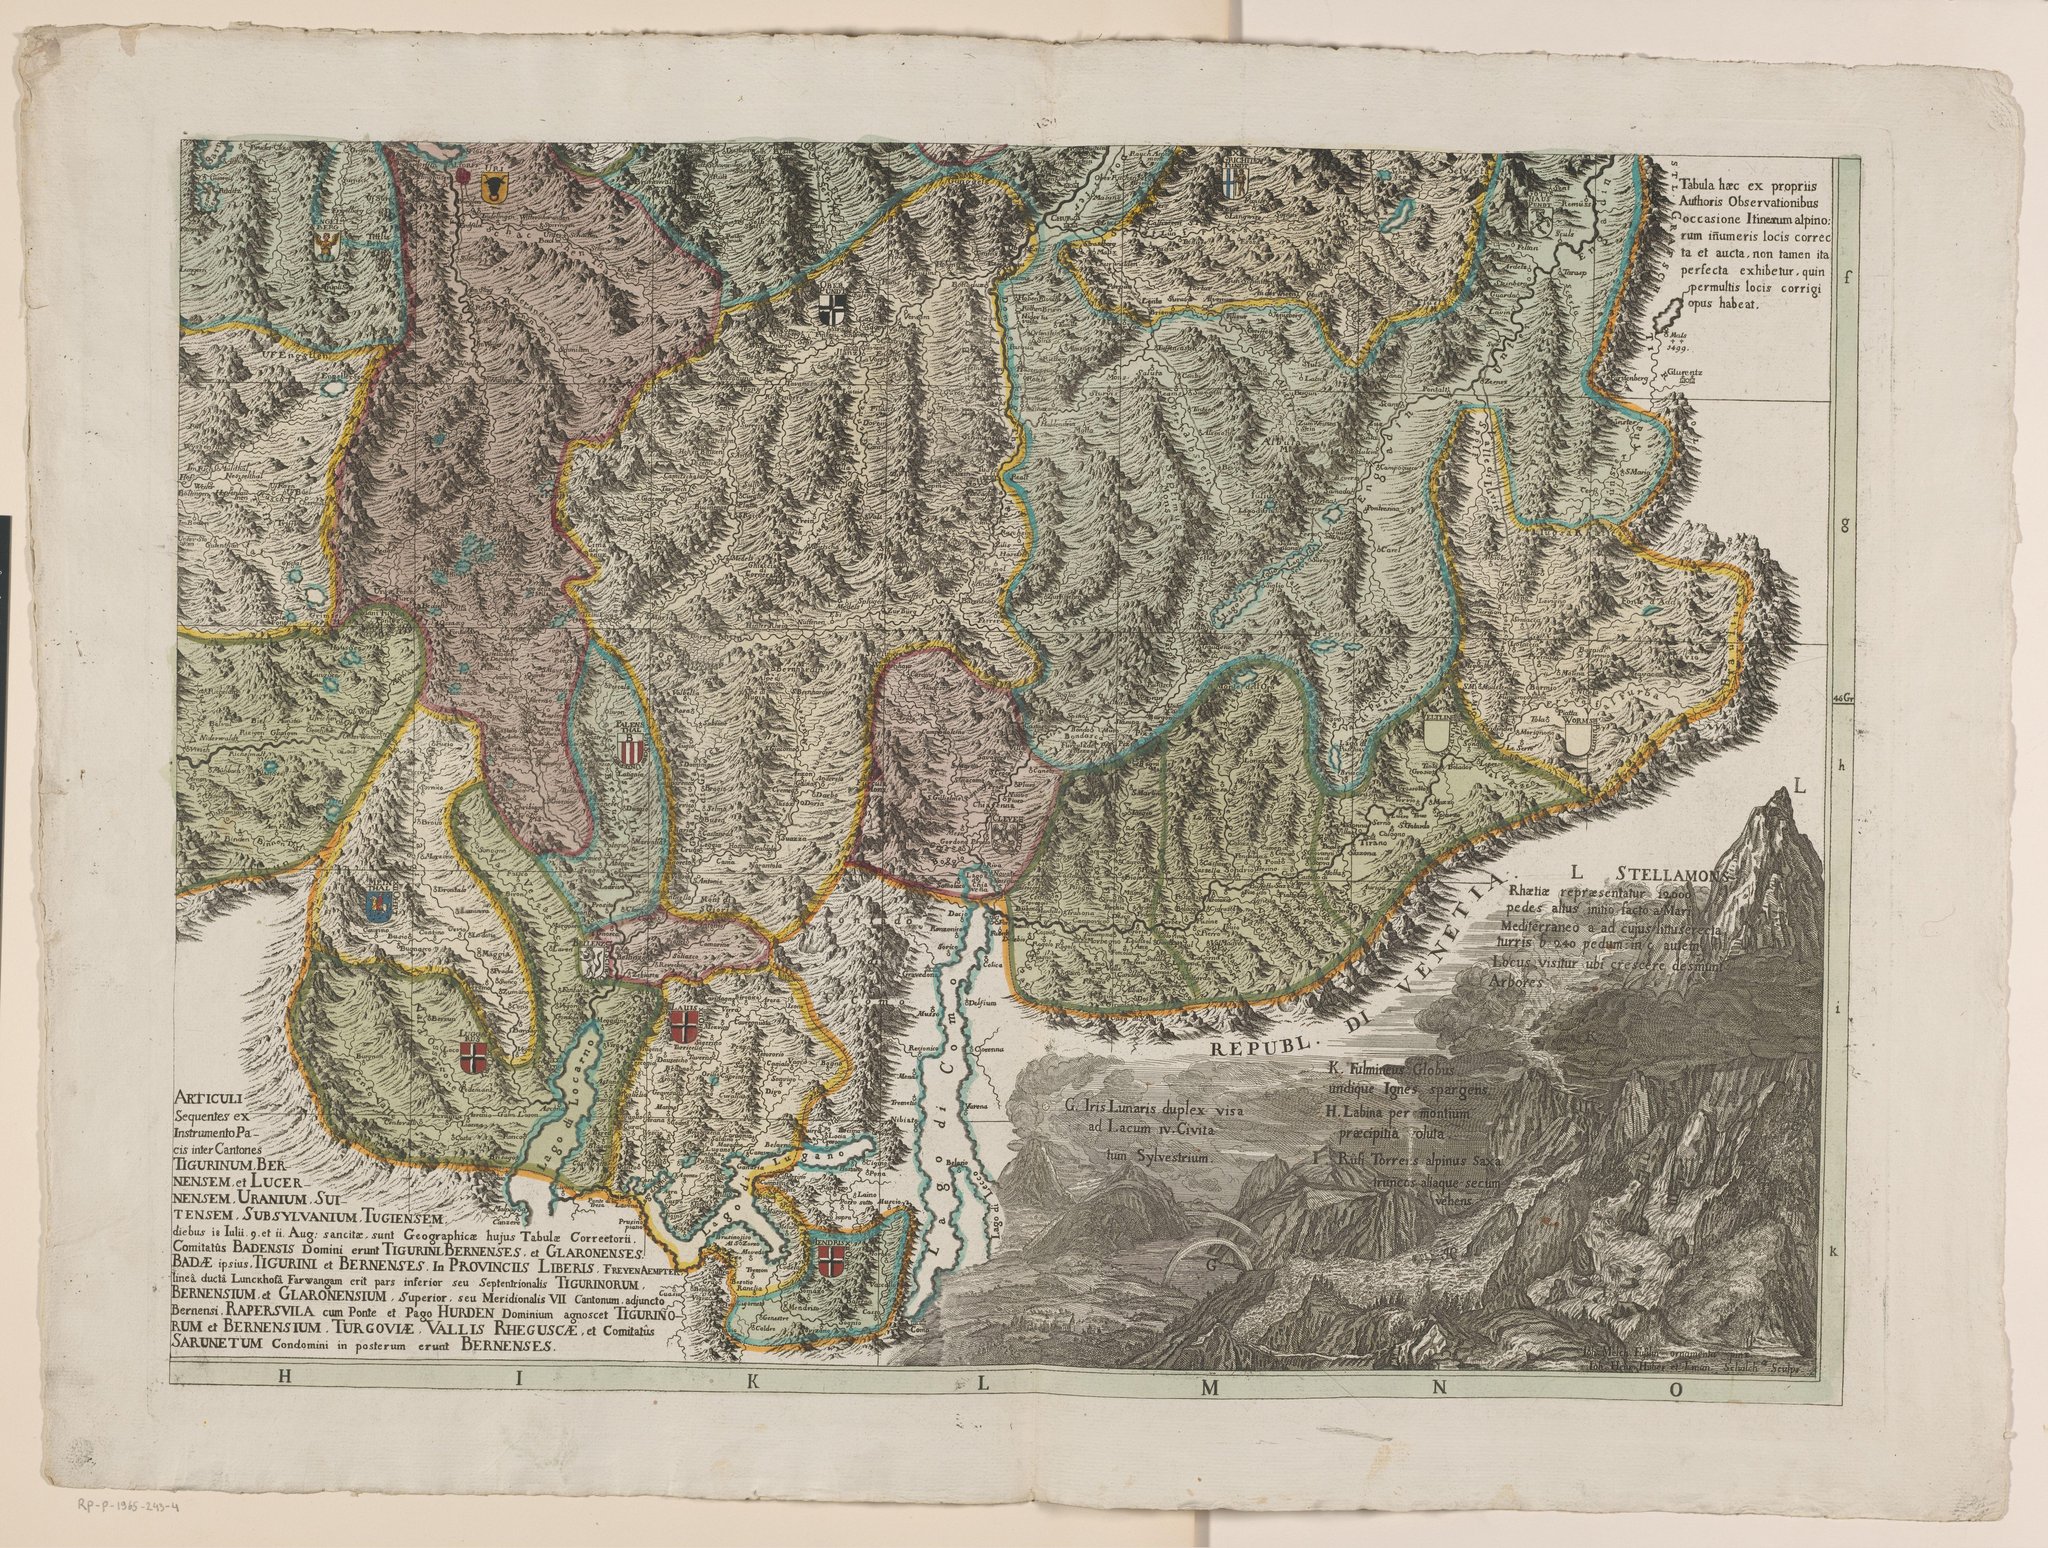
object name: print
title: Deel van een vierdelige kaart van Zwitserland (rechtsonder)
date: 1712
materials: paper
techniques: engraving, etching, hand coloring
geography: zurich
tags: coat of arms (as symbol of the state, etc.) (+ city; municipal), maps of separate countries or regions, river personified, 'fiumi' (ripa), coat of arms (as symbol of the state, etc.) (+ province; provincial), switzerland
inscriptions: collector's mark: Lugt 2228, collector's mark: Lugt 2760